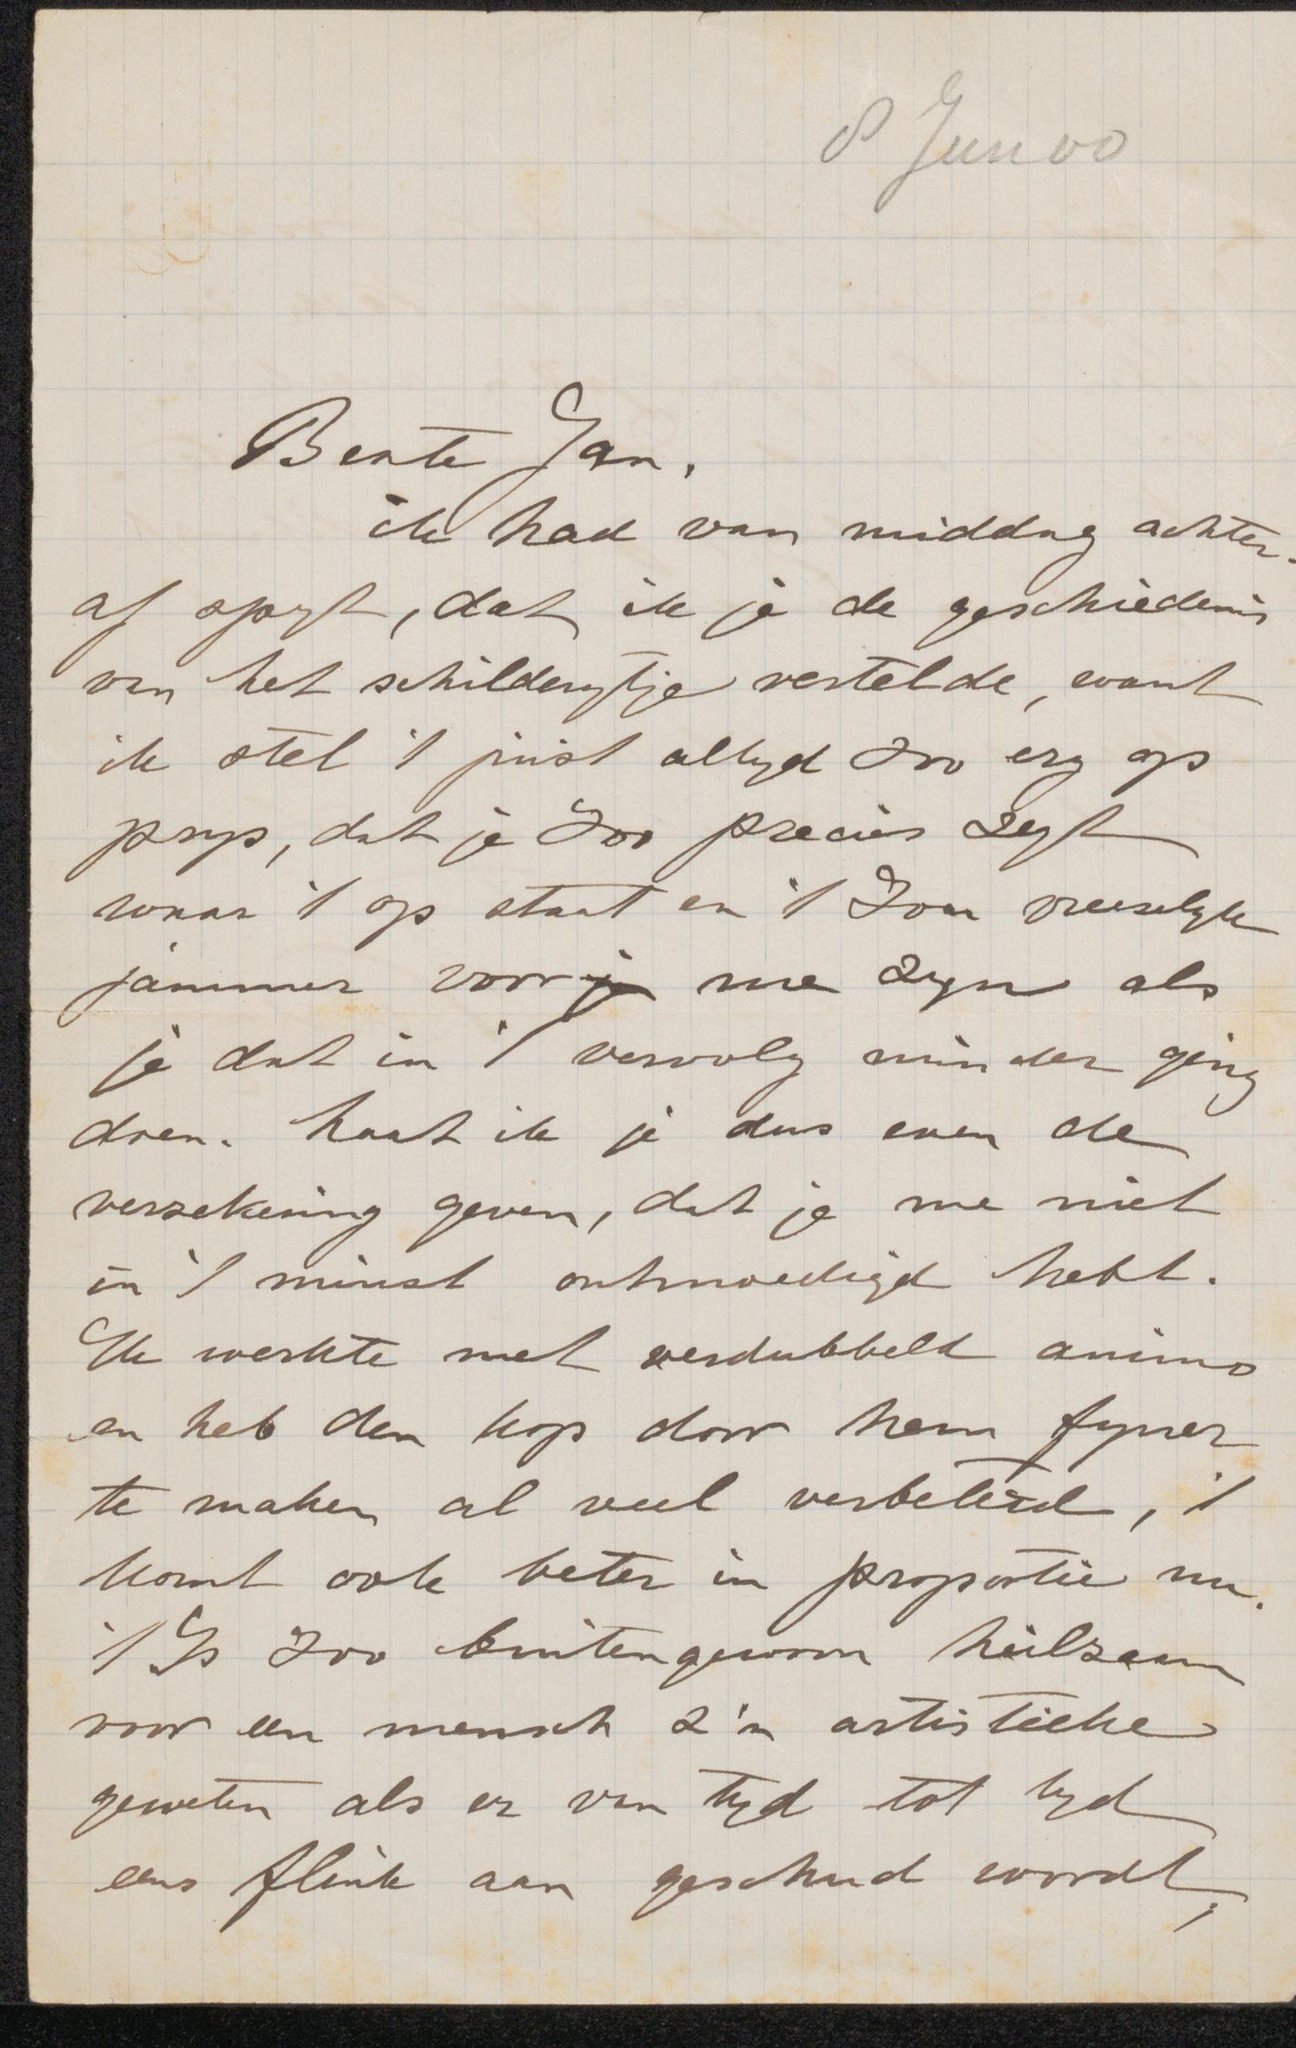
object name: letter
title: Brief aan Jan Veth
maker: wally moes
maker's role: draughtsman, print maker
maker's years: 1856-1918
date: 1874-1918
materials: ink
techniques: pen, writing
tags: dordrecht, painter, designer, jan veth, den bosch, antoon derkinderen, painting (including book-illumination, miniature-painting)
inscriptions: collector's mark: ‘RPK’